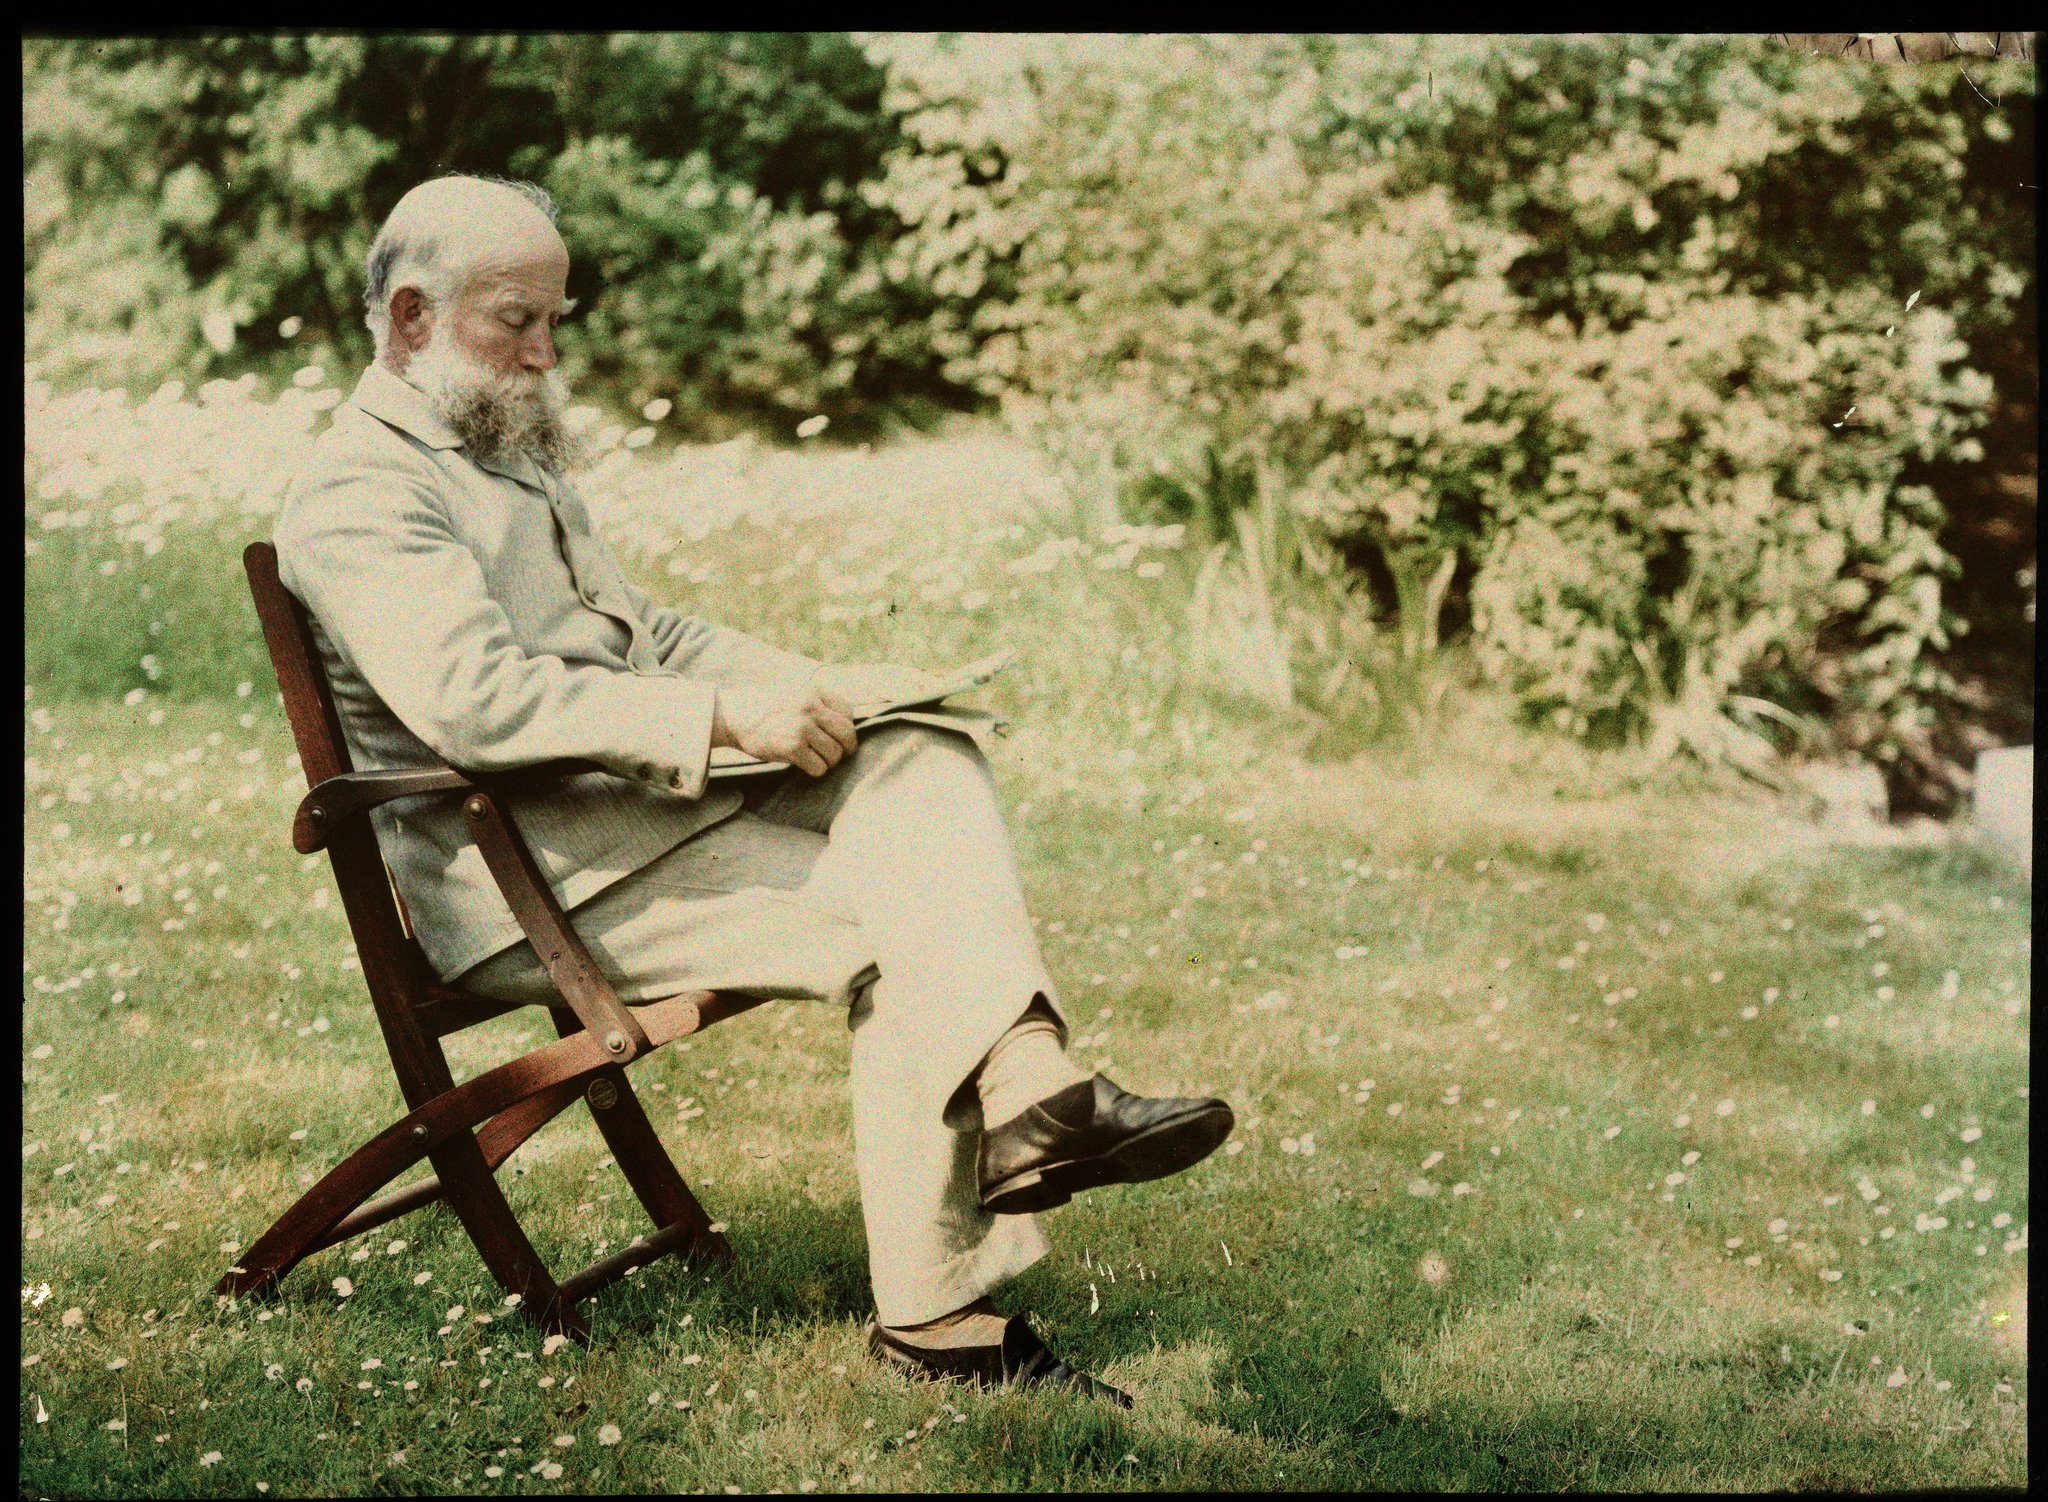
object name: photograph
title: Oude man met baard zittend in een stoel in een grasveld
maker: adolphe burdet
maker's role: fotograaf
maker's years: 1860-1940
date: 1907-1930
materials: glass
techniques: autochrome process, slide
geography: netherlands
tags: adolphe burdet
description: Man met baard zittend in een stoel in een grasveld.